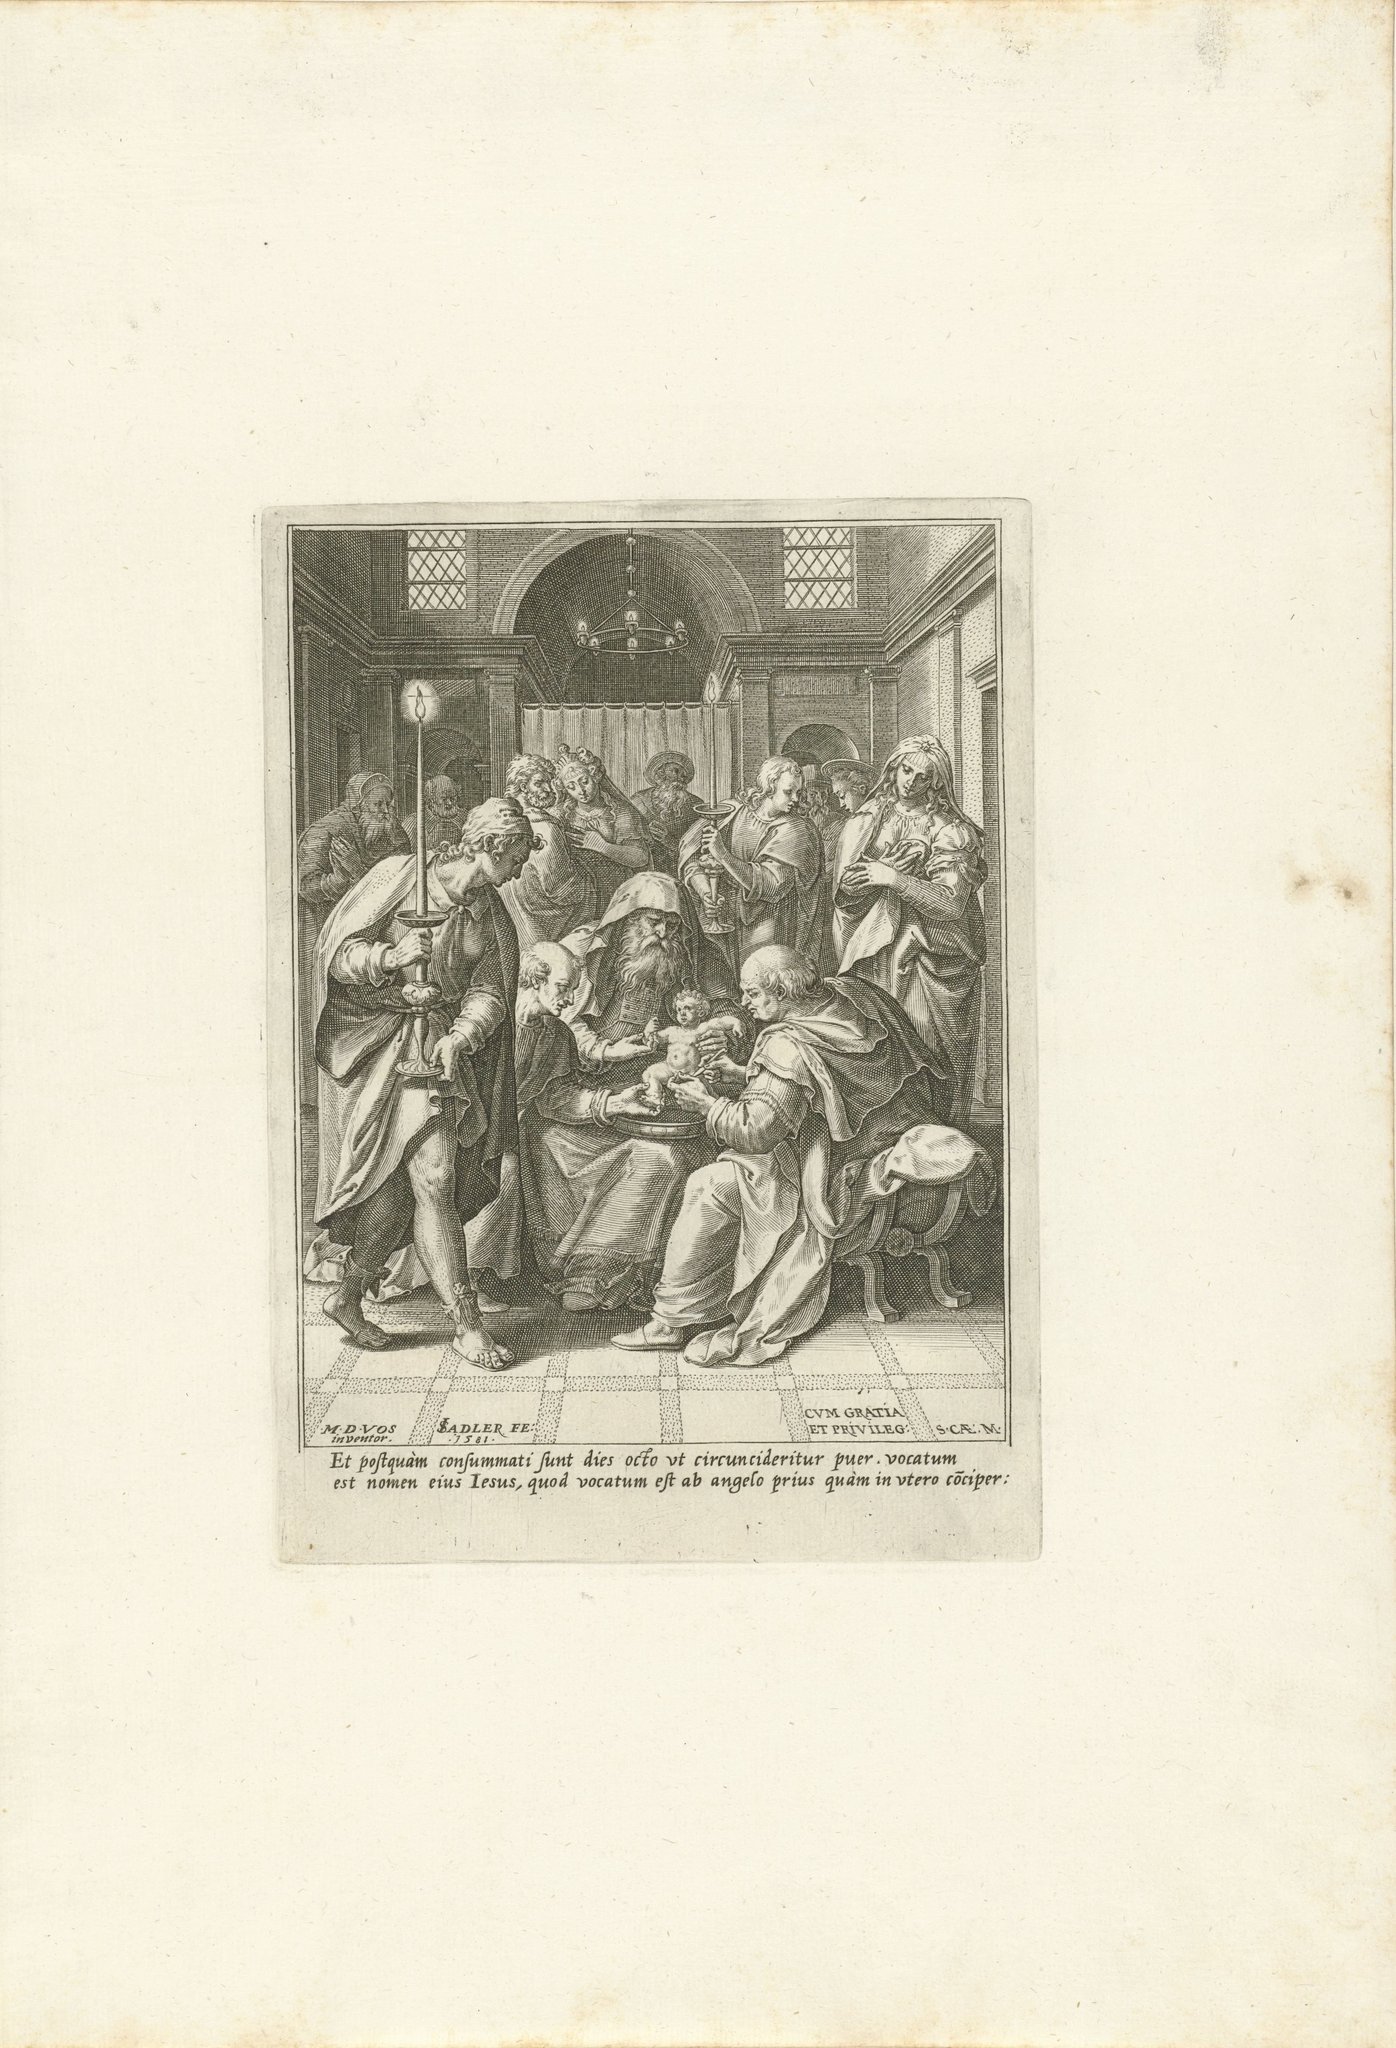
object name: print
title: Geboorte en eerste jaren van Christus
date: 1581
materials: paper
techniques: engraving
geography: cologne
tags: circumcision of the christ-child by mary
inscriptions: collector's mark: Lugt 2760, collector's mark: Lugt 2228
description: De hogepriester besnijdt het Christuskind. Maria en Jozef kijken samen met anderen toe. De prent heeft een Latijns Bijbelcitaat als onderschrift en is de vijfde prent van een twaalfdelige serie over de geboorte en de eerste jaren van Christus.